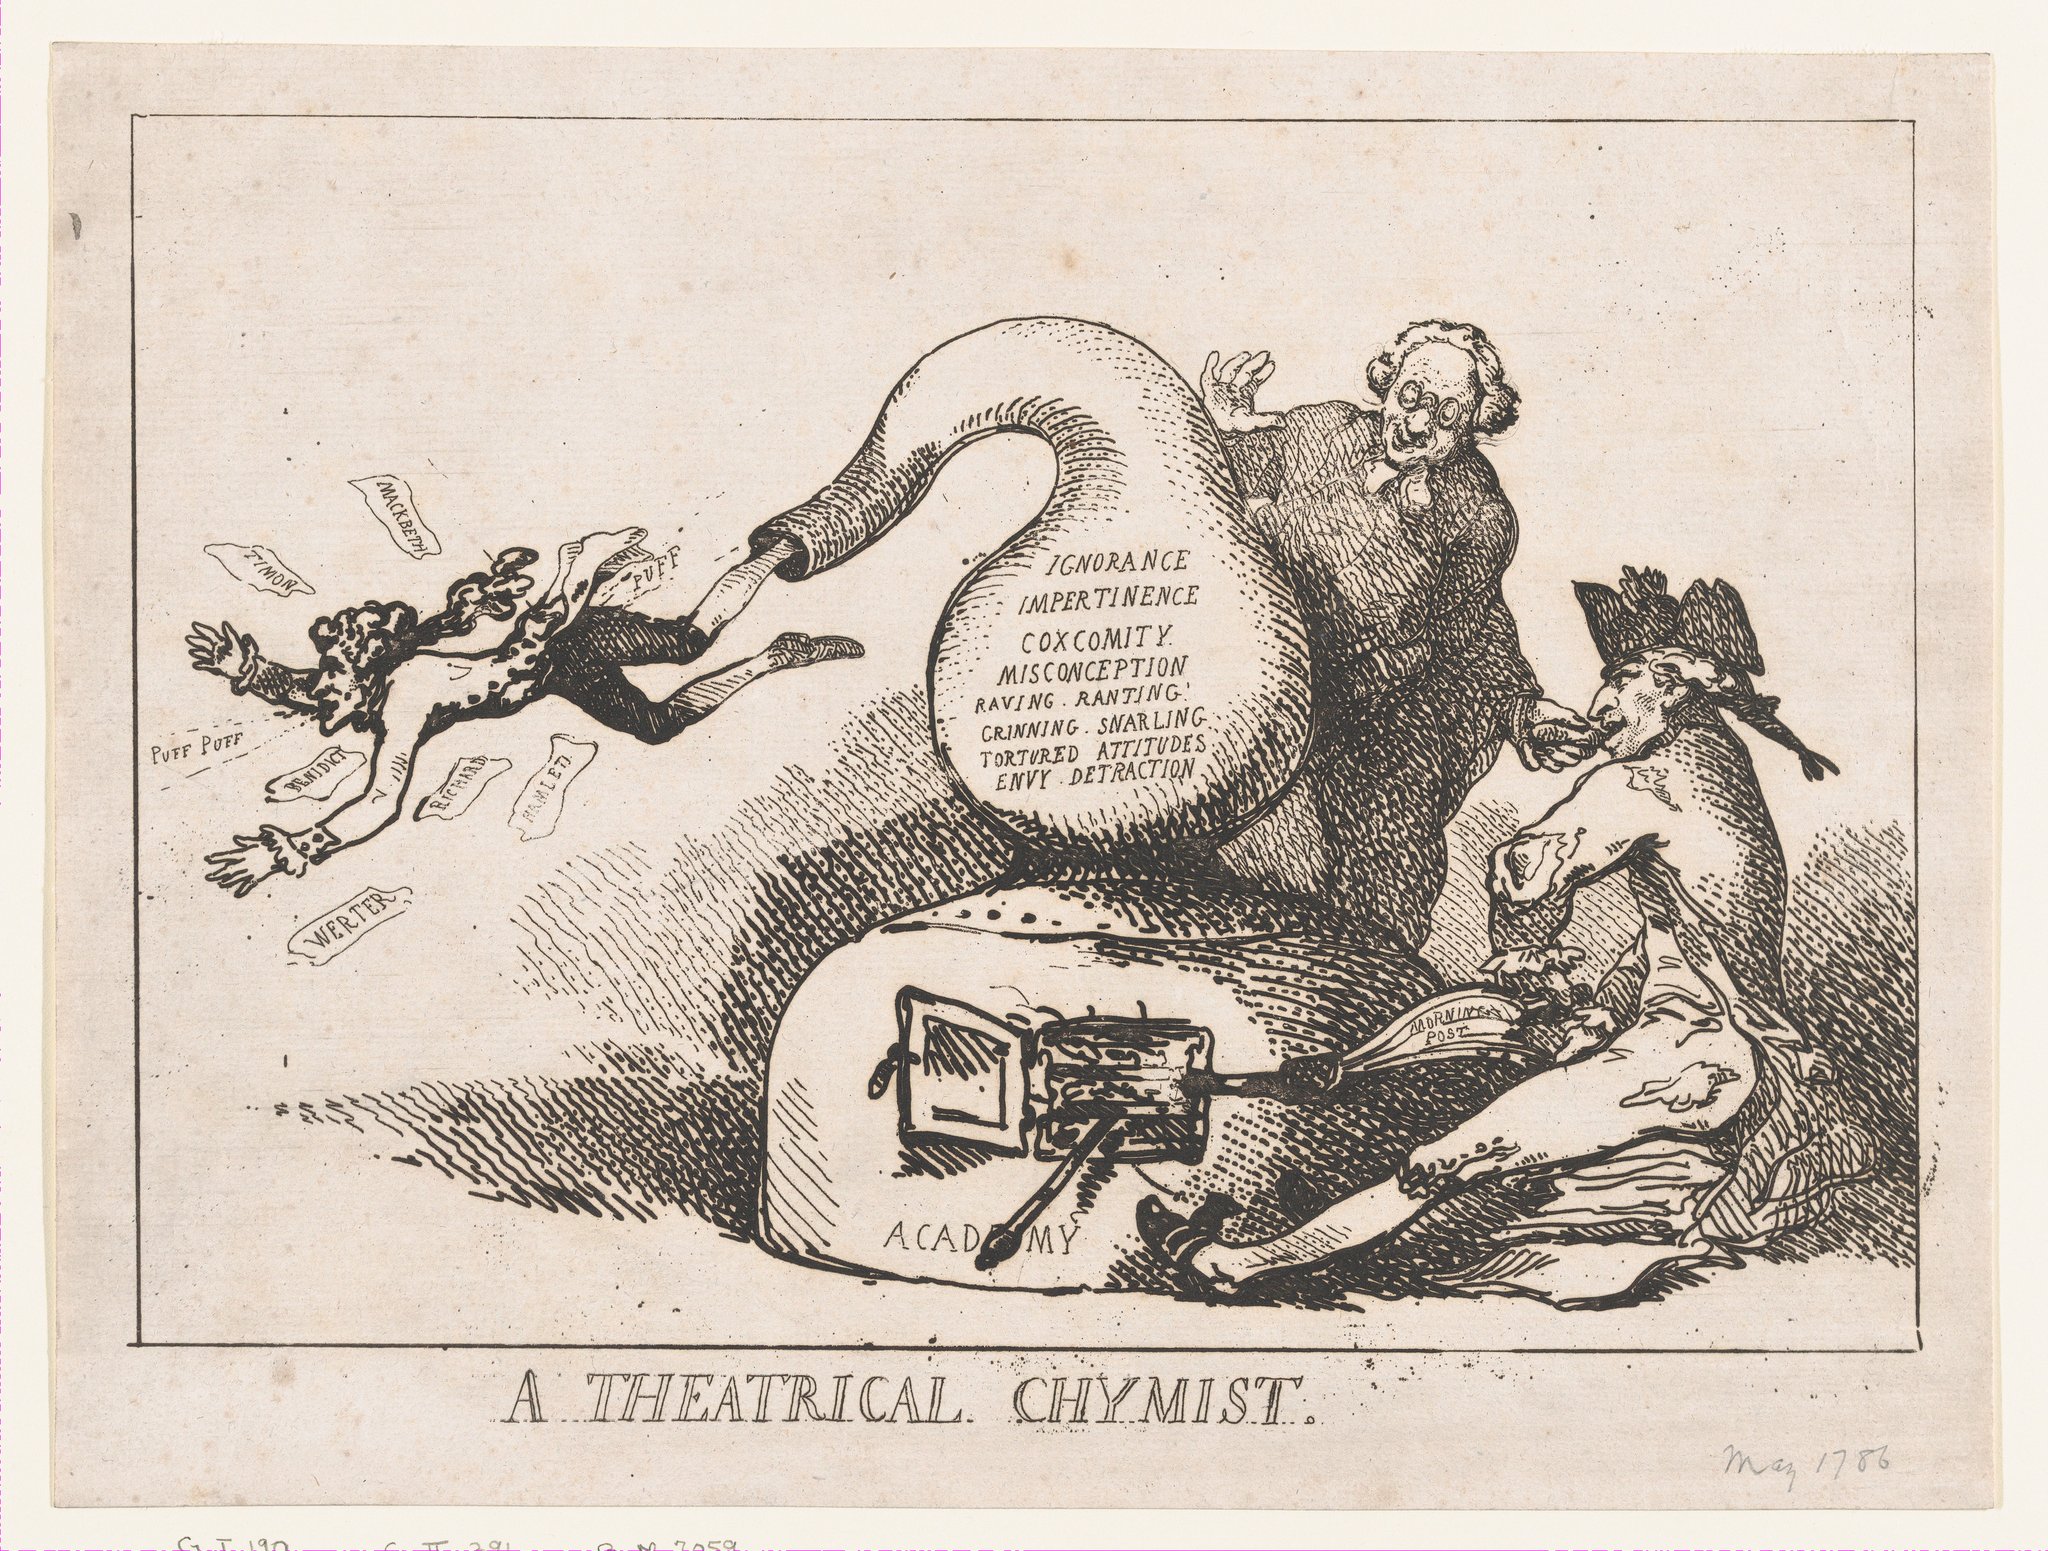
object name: print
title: A Theatrical Chymist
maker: thomas rowlandson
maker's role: artist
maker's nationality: british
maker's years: 1757-1827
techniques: etching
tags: satire,men